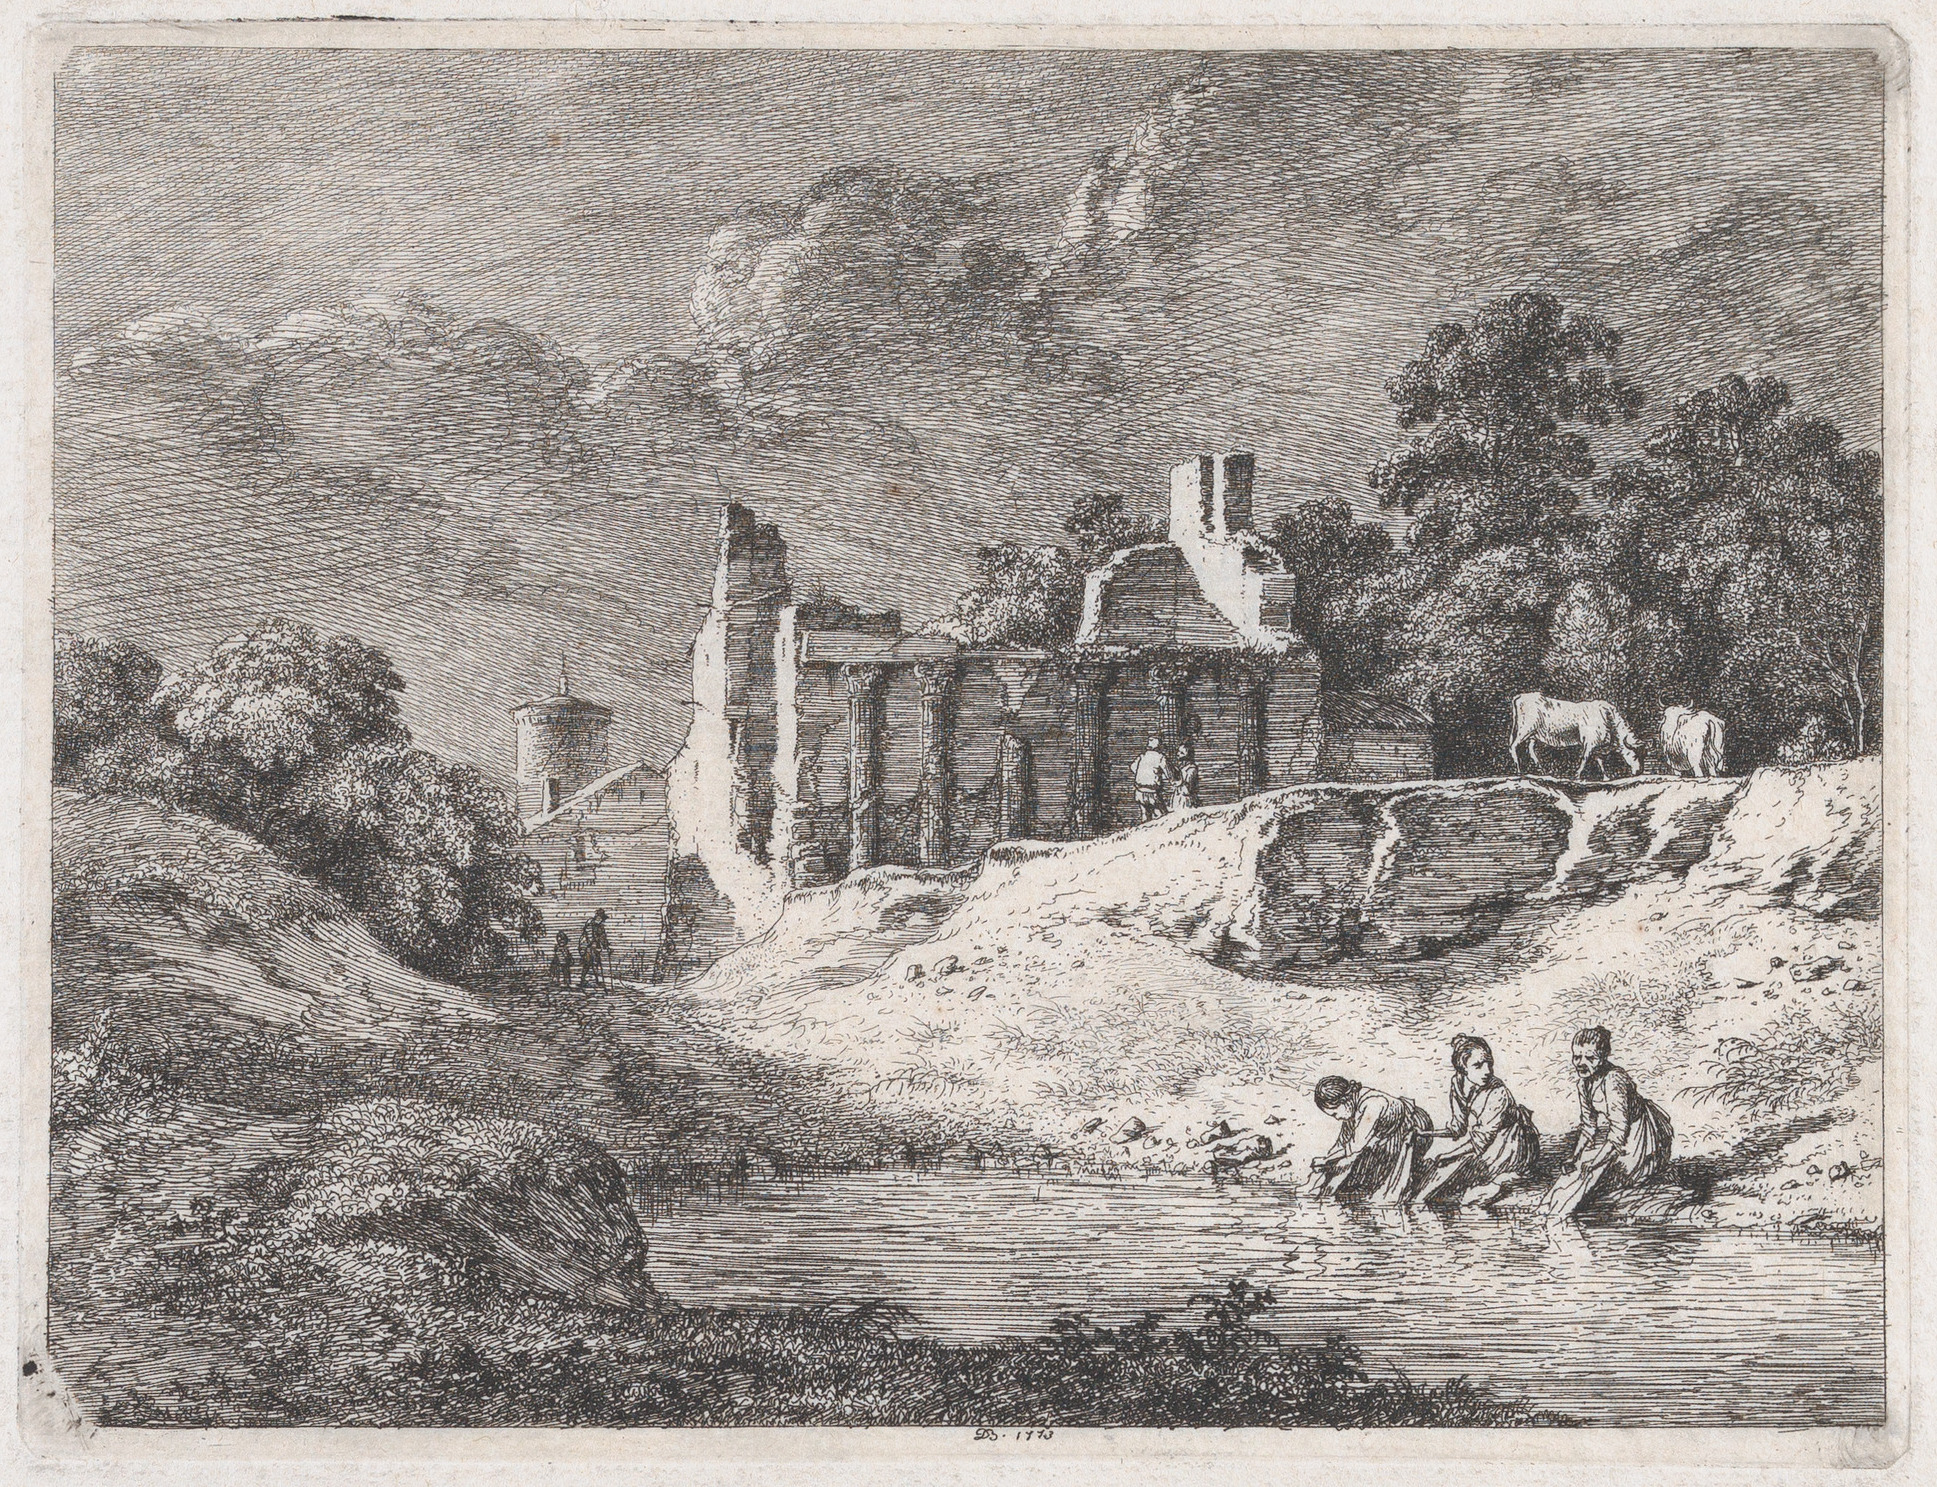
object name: print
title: Washerwomen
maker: jean jacques de boissieu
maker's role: artist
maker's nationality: french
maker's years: 1736-1810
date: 1773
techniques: etching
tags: ruins,women,cows,washing